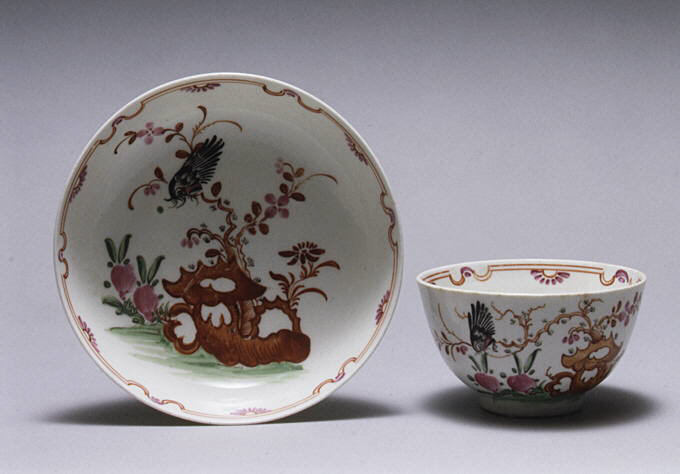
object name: teabowl and saucer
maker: lowestoft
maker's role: factory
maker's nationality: british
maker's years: 1757-1803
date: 1770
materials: hard paste porcelain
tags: birds,plants